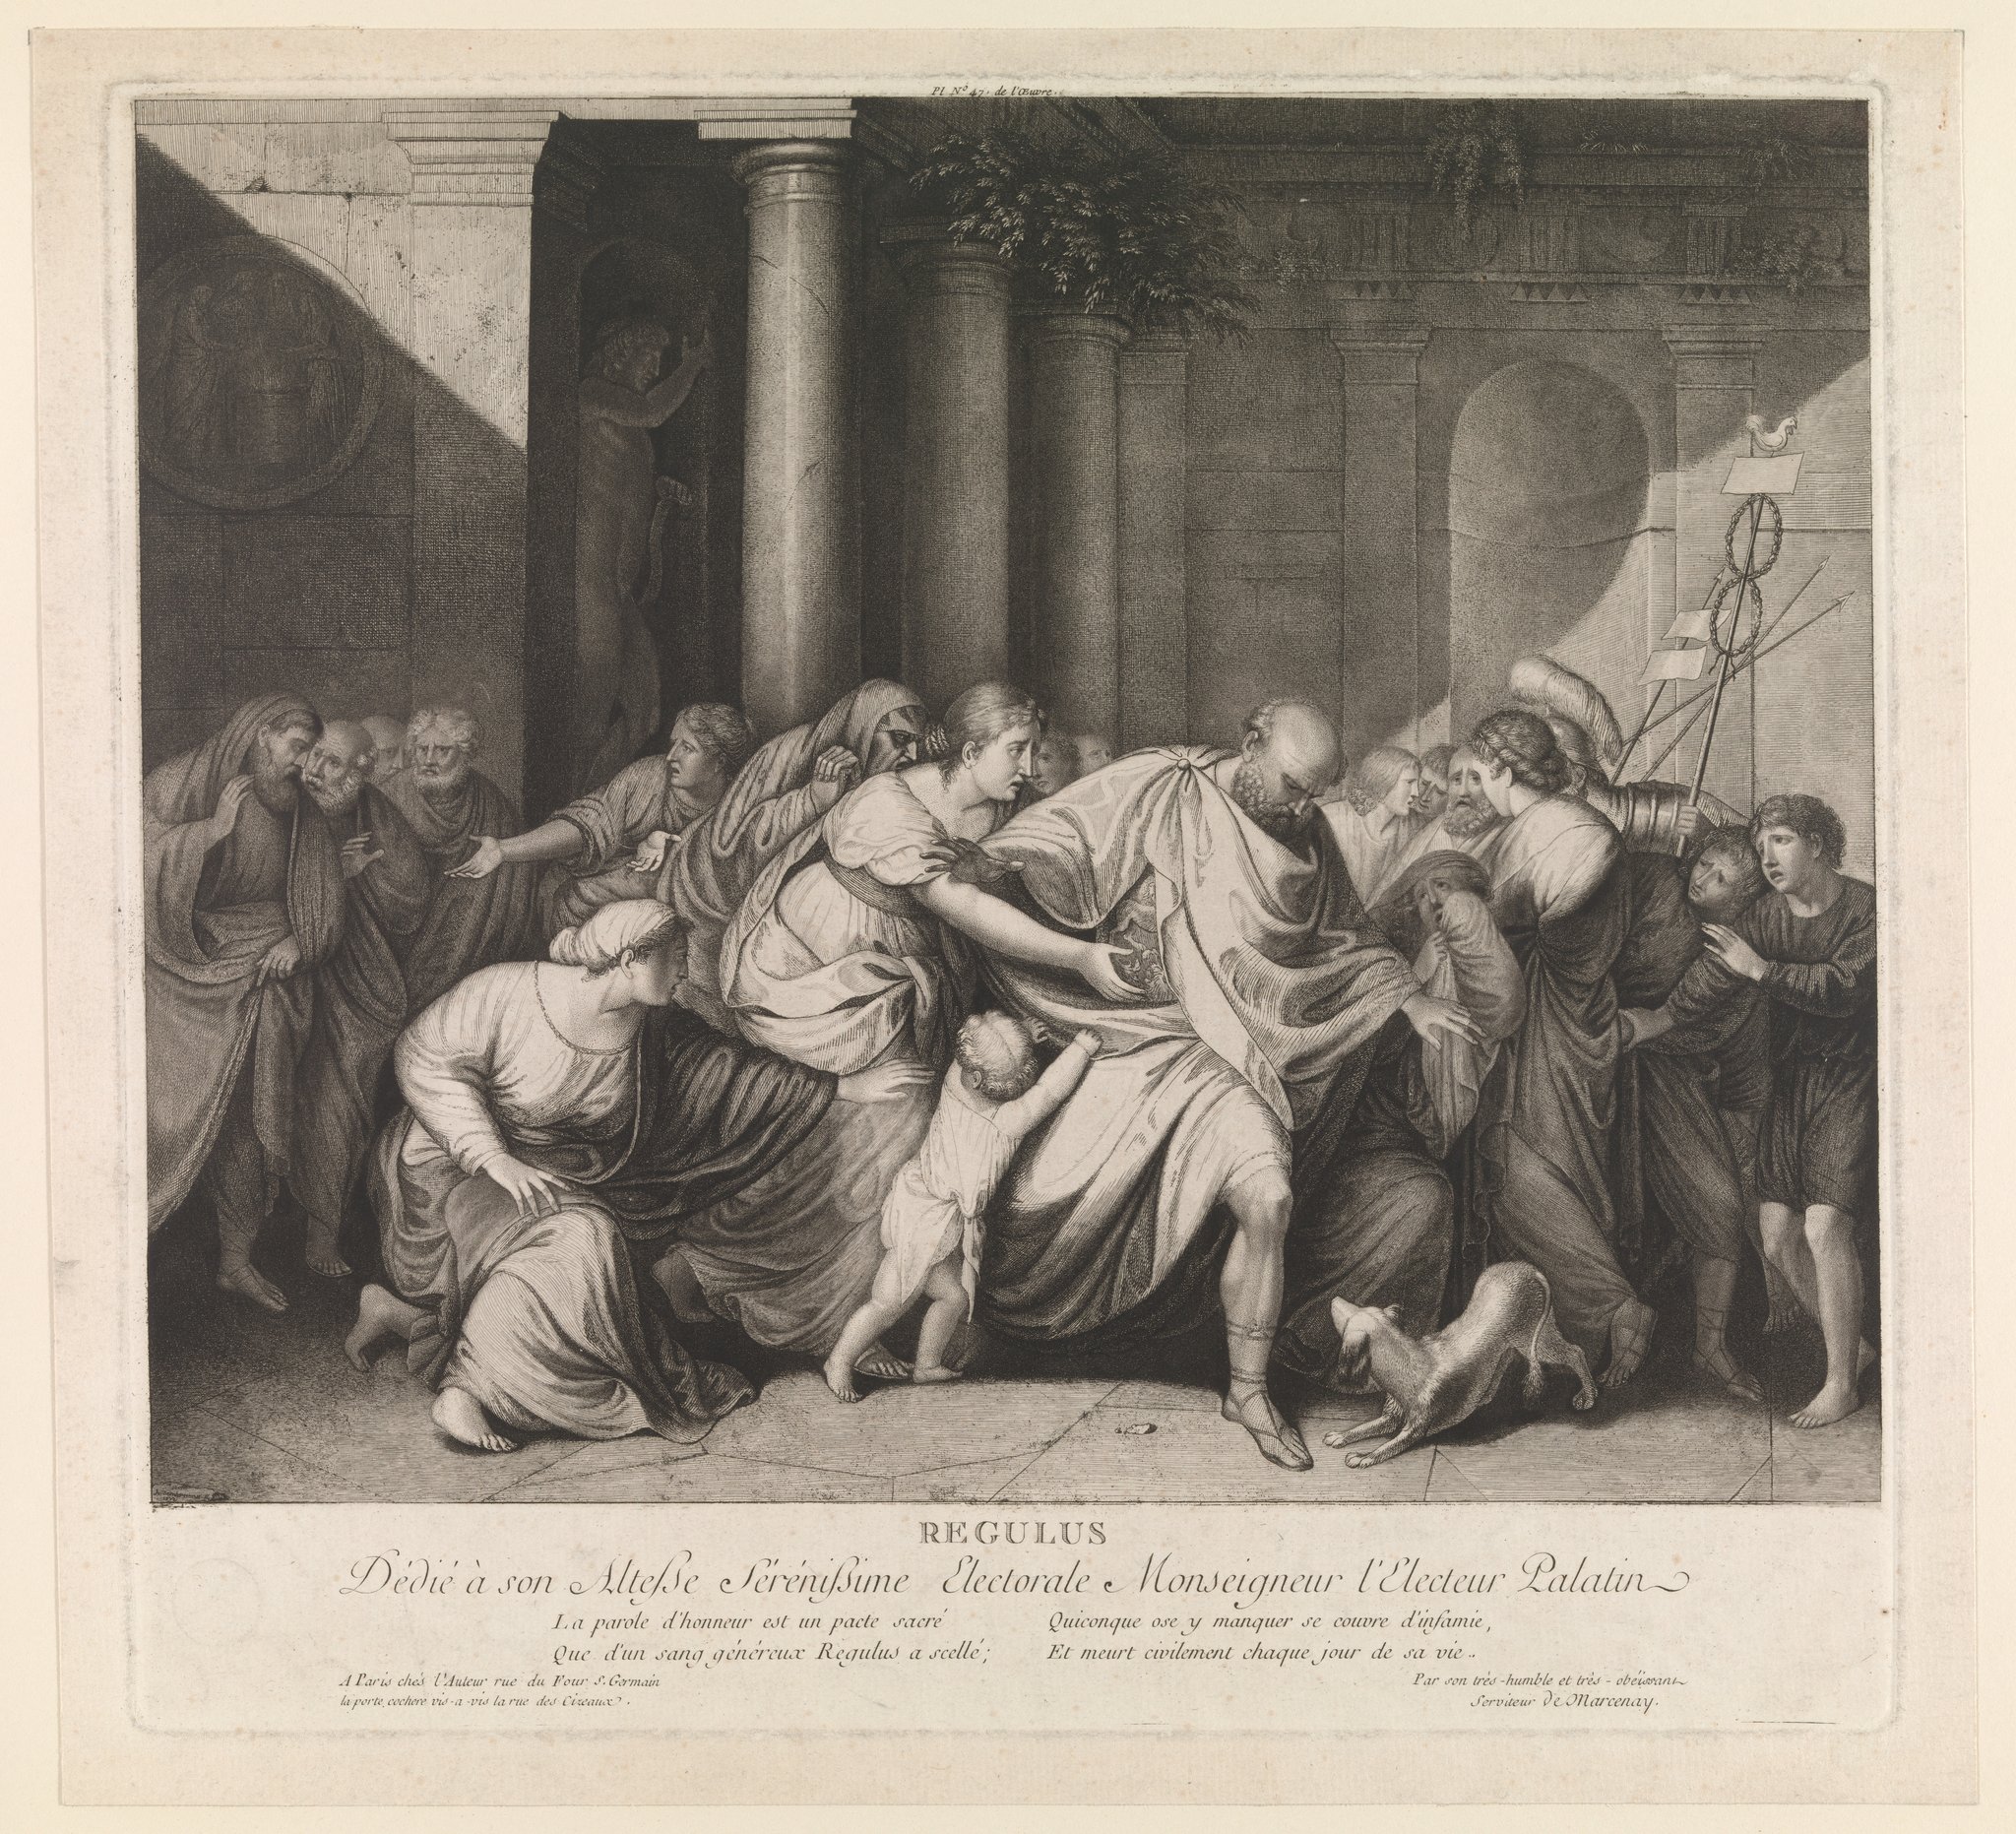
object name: print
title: Regulus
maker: antoine de marcenay de ghuy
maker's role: artist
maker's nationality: french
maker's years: 1724-1811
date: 1772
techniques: etching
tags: children,men,women,dogs